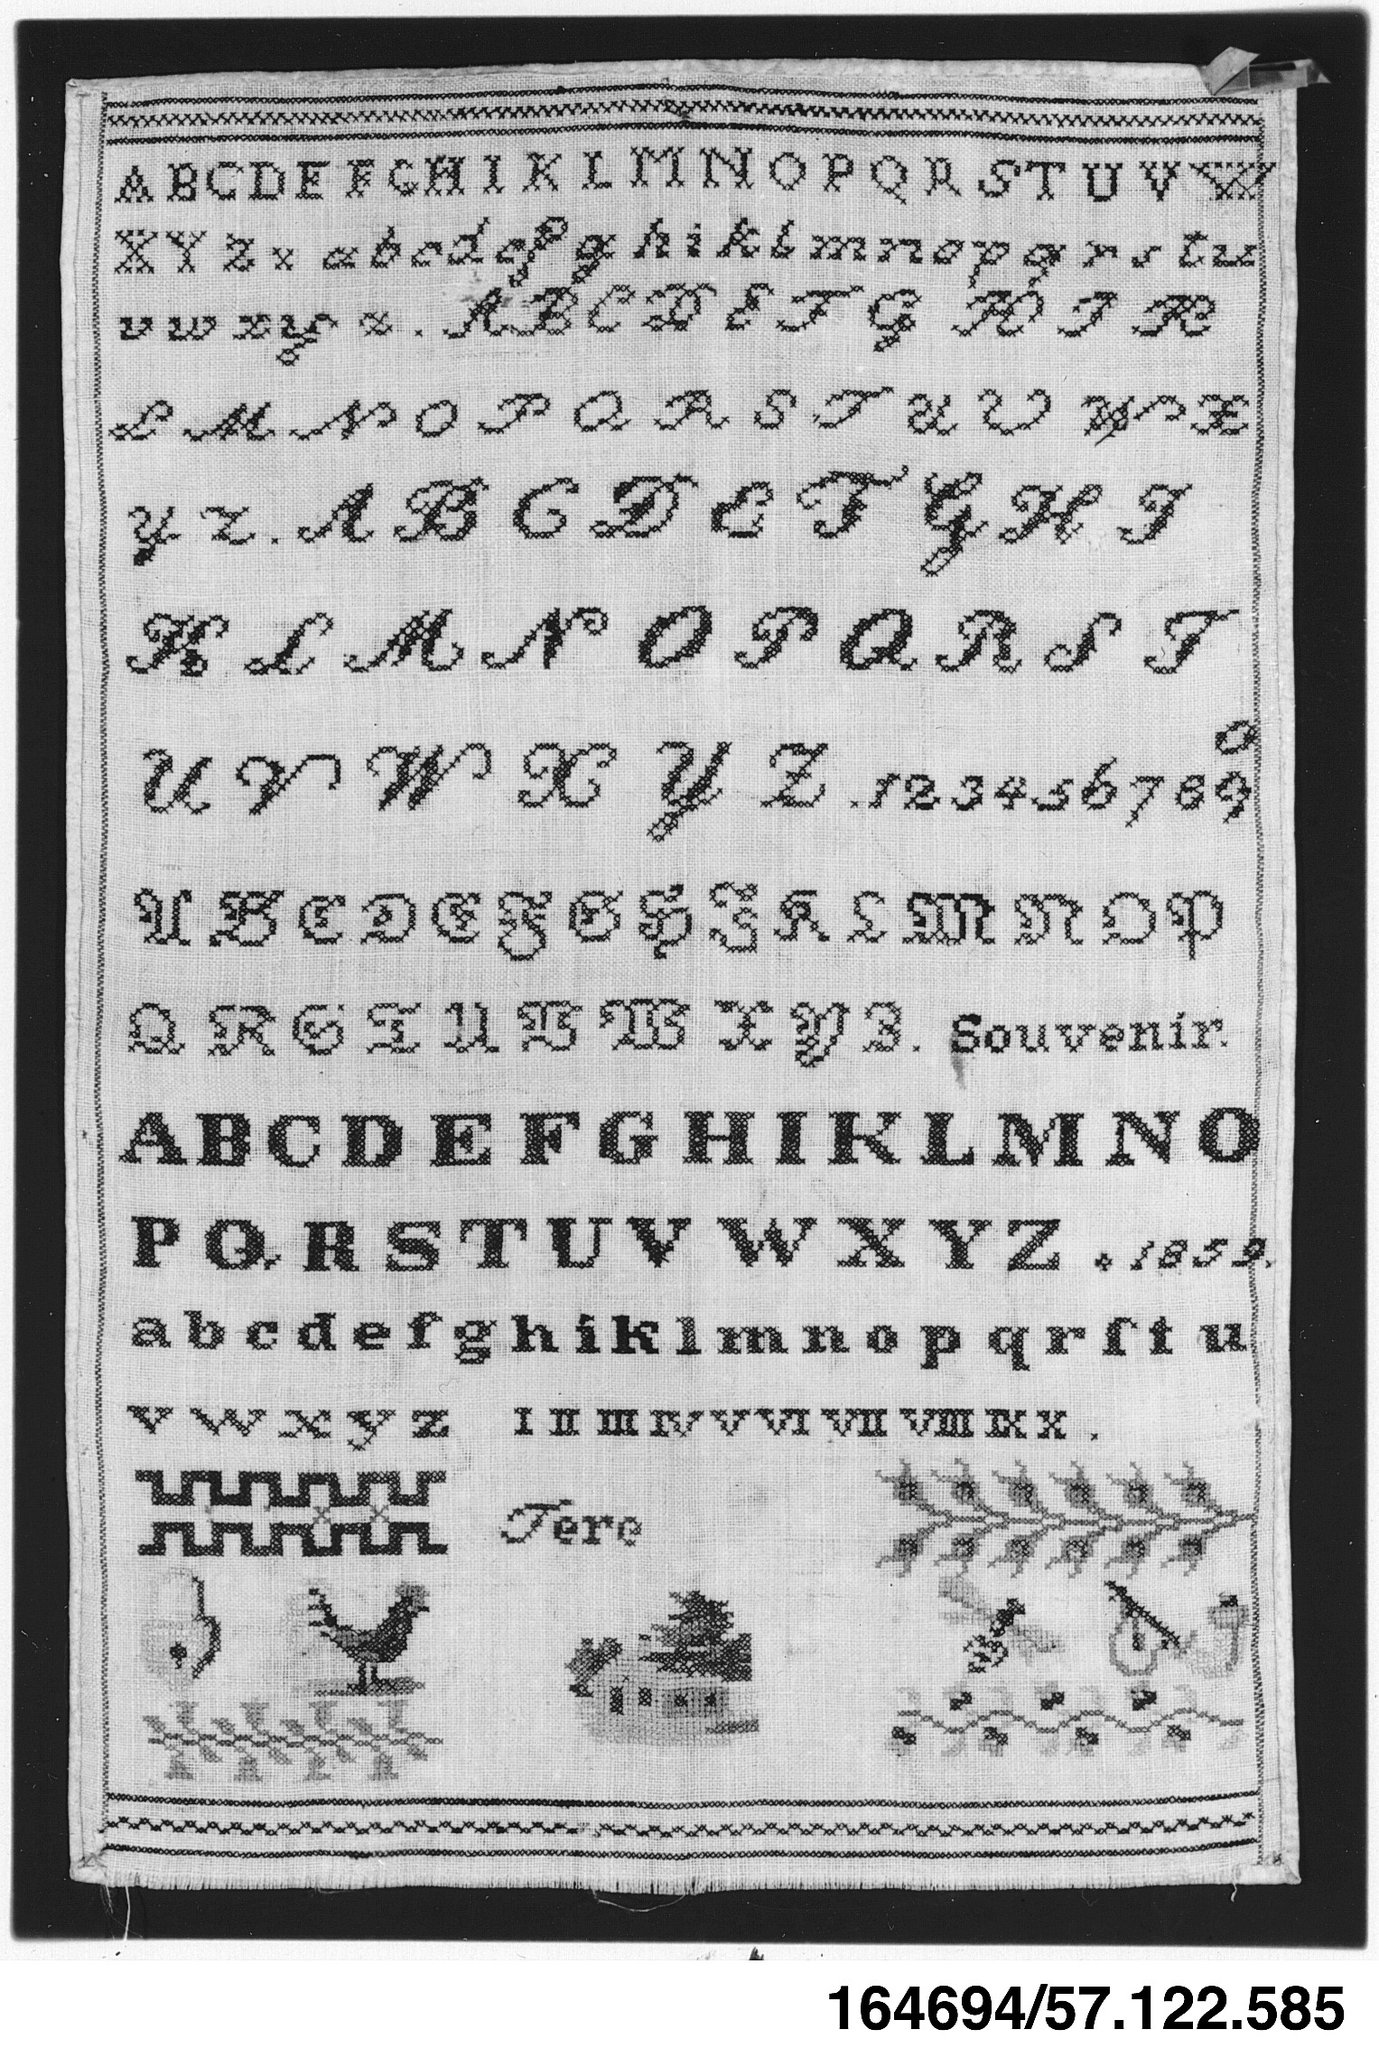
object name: sampler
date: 1859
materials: canvas, silk, wool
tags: birds,houses